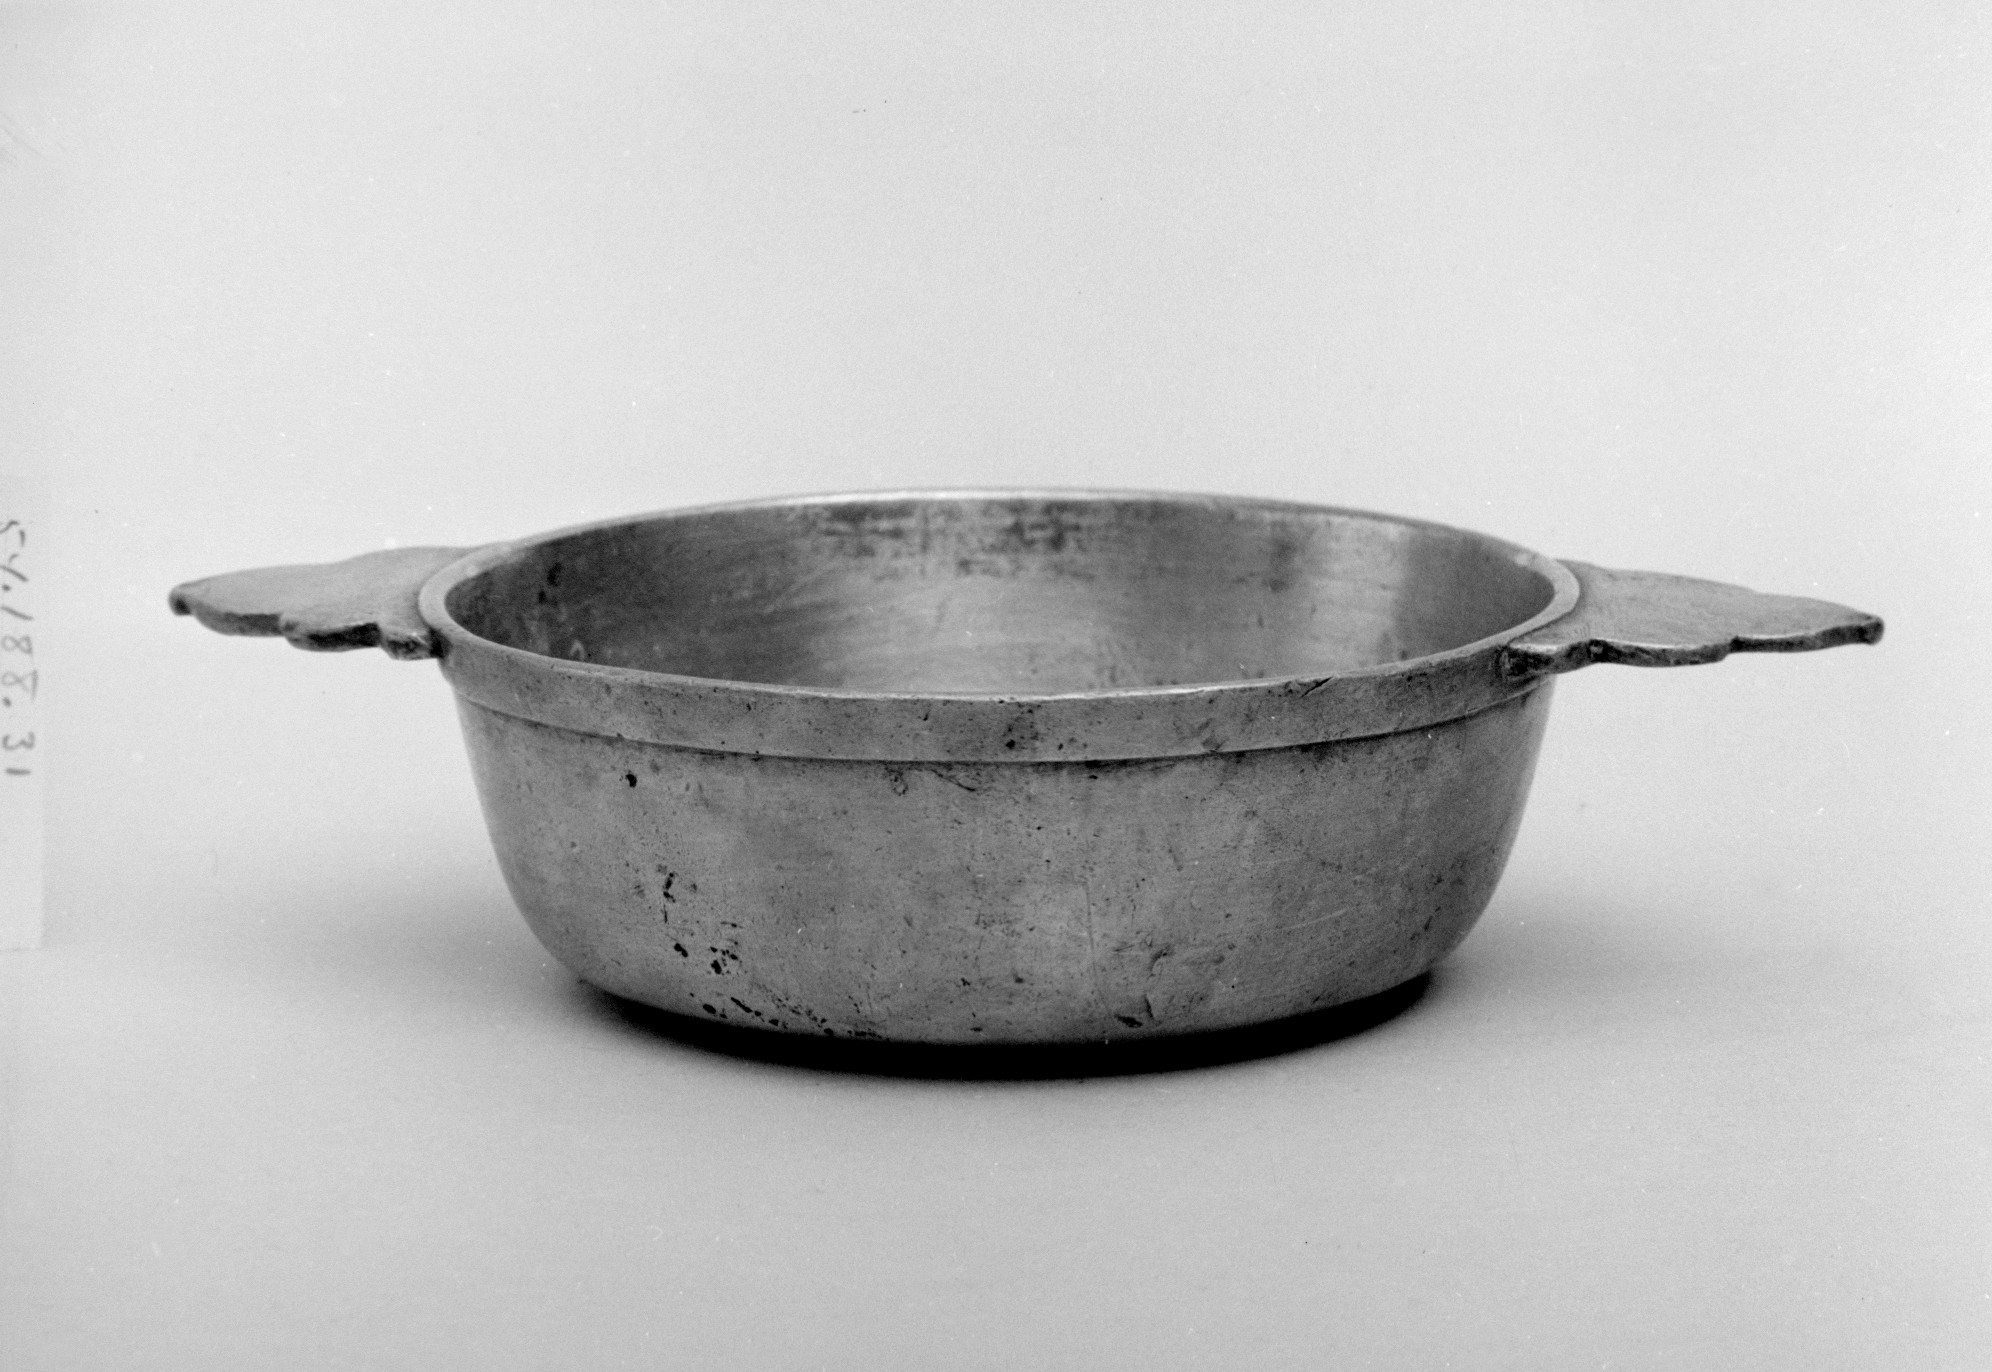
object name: bowl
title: Bowl (from a set of four)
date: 1701-1800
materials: pewter